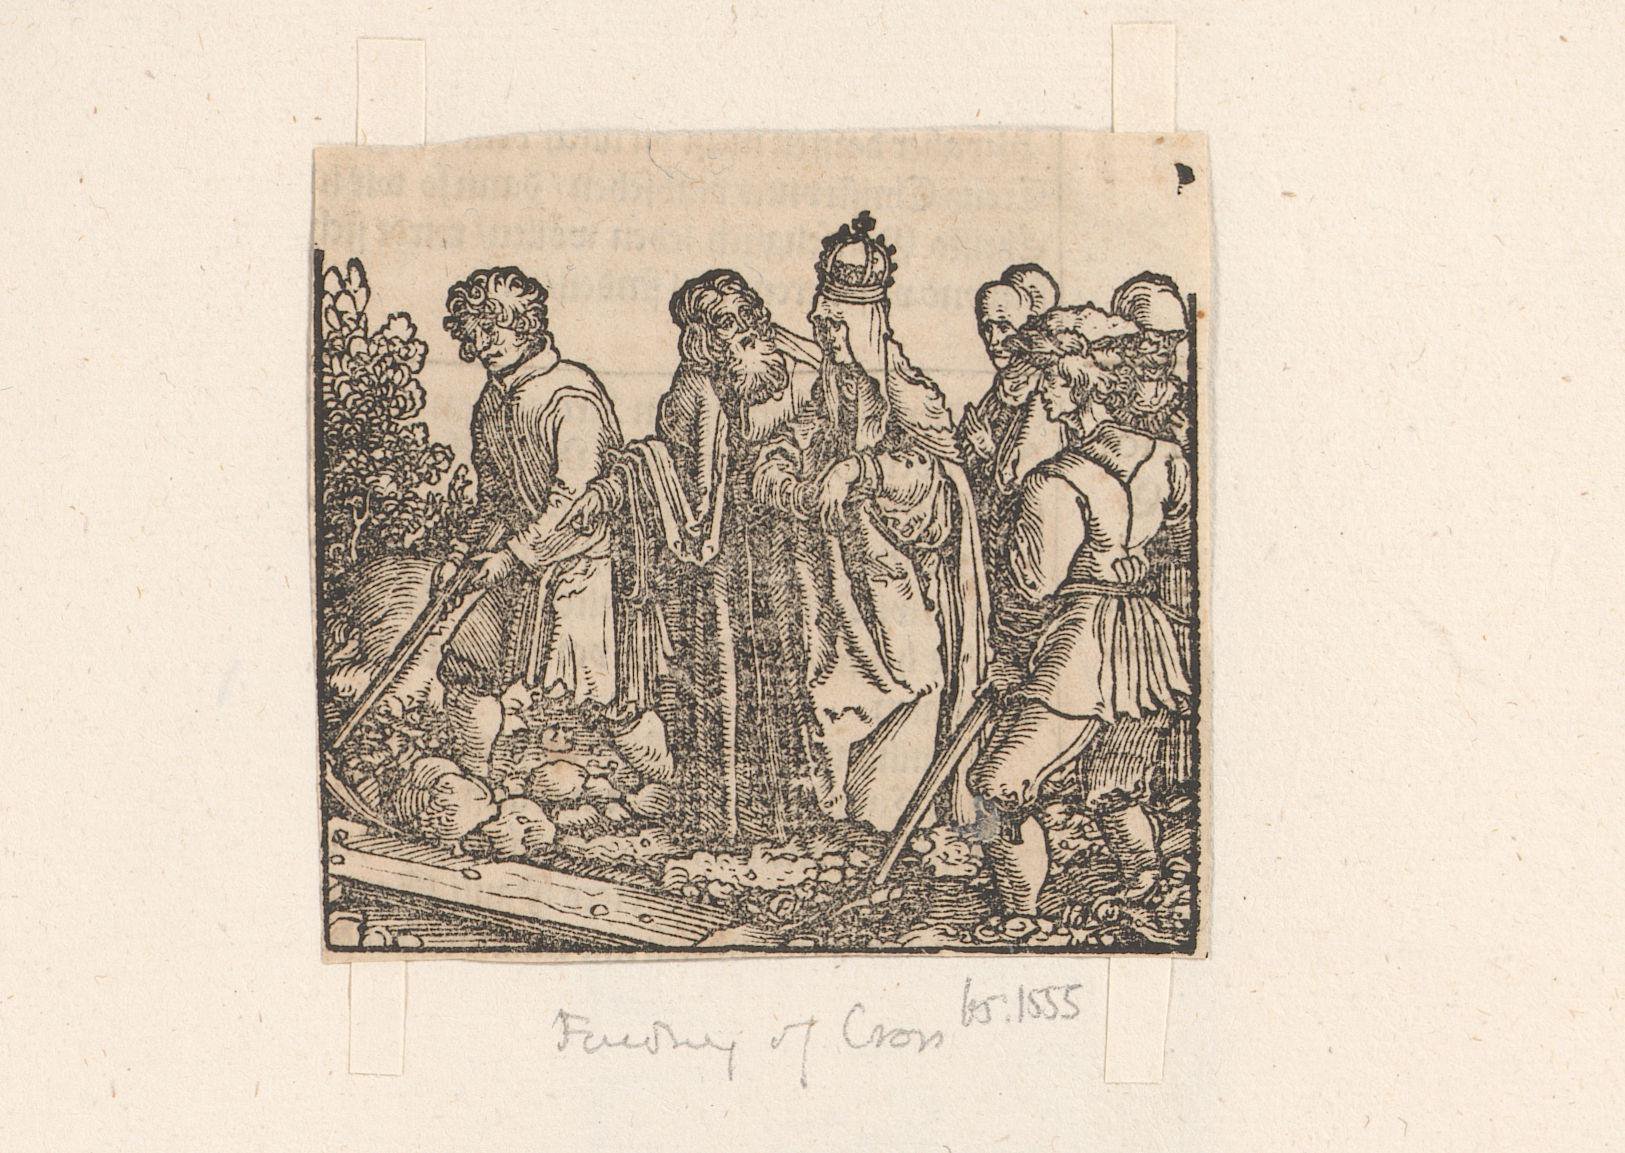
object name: album leaf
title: H. Helena vindt het ware kruis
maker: Anonymous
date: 1500-1536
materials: paper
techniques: woodcut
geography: germany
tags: the finding of the true cross, empress helena, mother of constantine the great; possible attributes: model of church, (royal) crown, crown of thorns, cross, three nails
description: Helena laat het ware kruis van Christus opgraven. Prent maakt deel uit van een album.